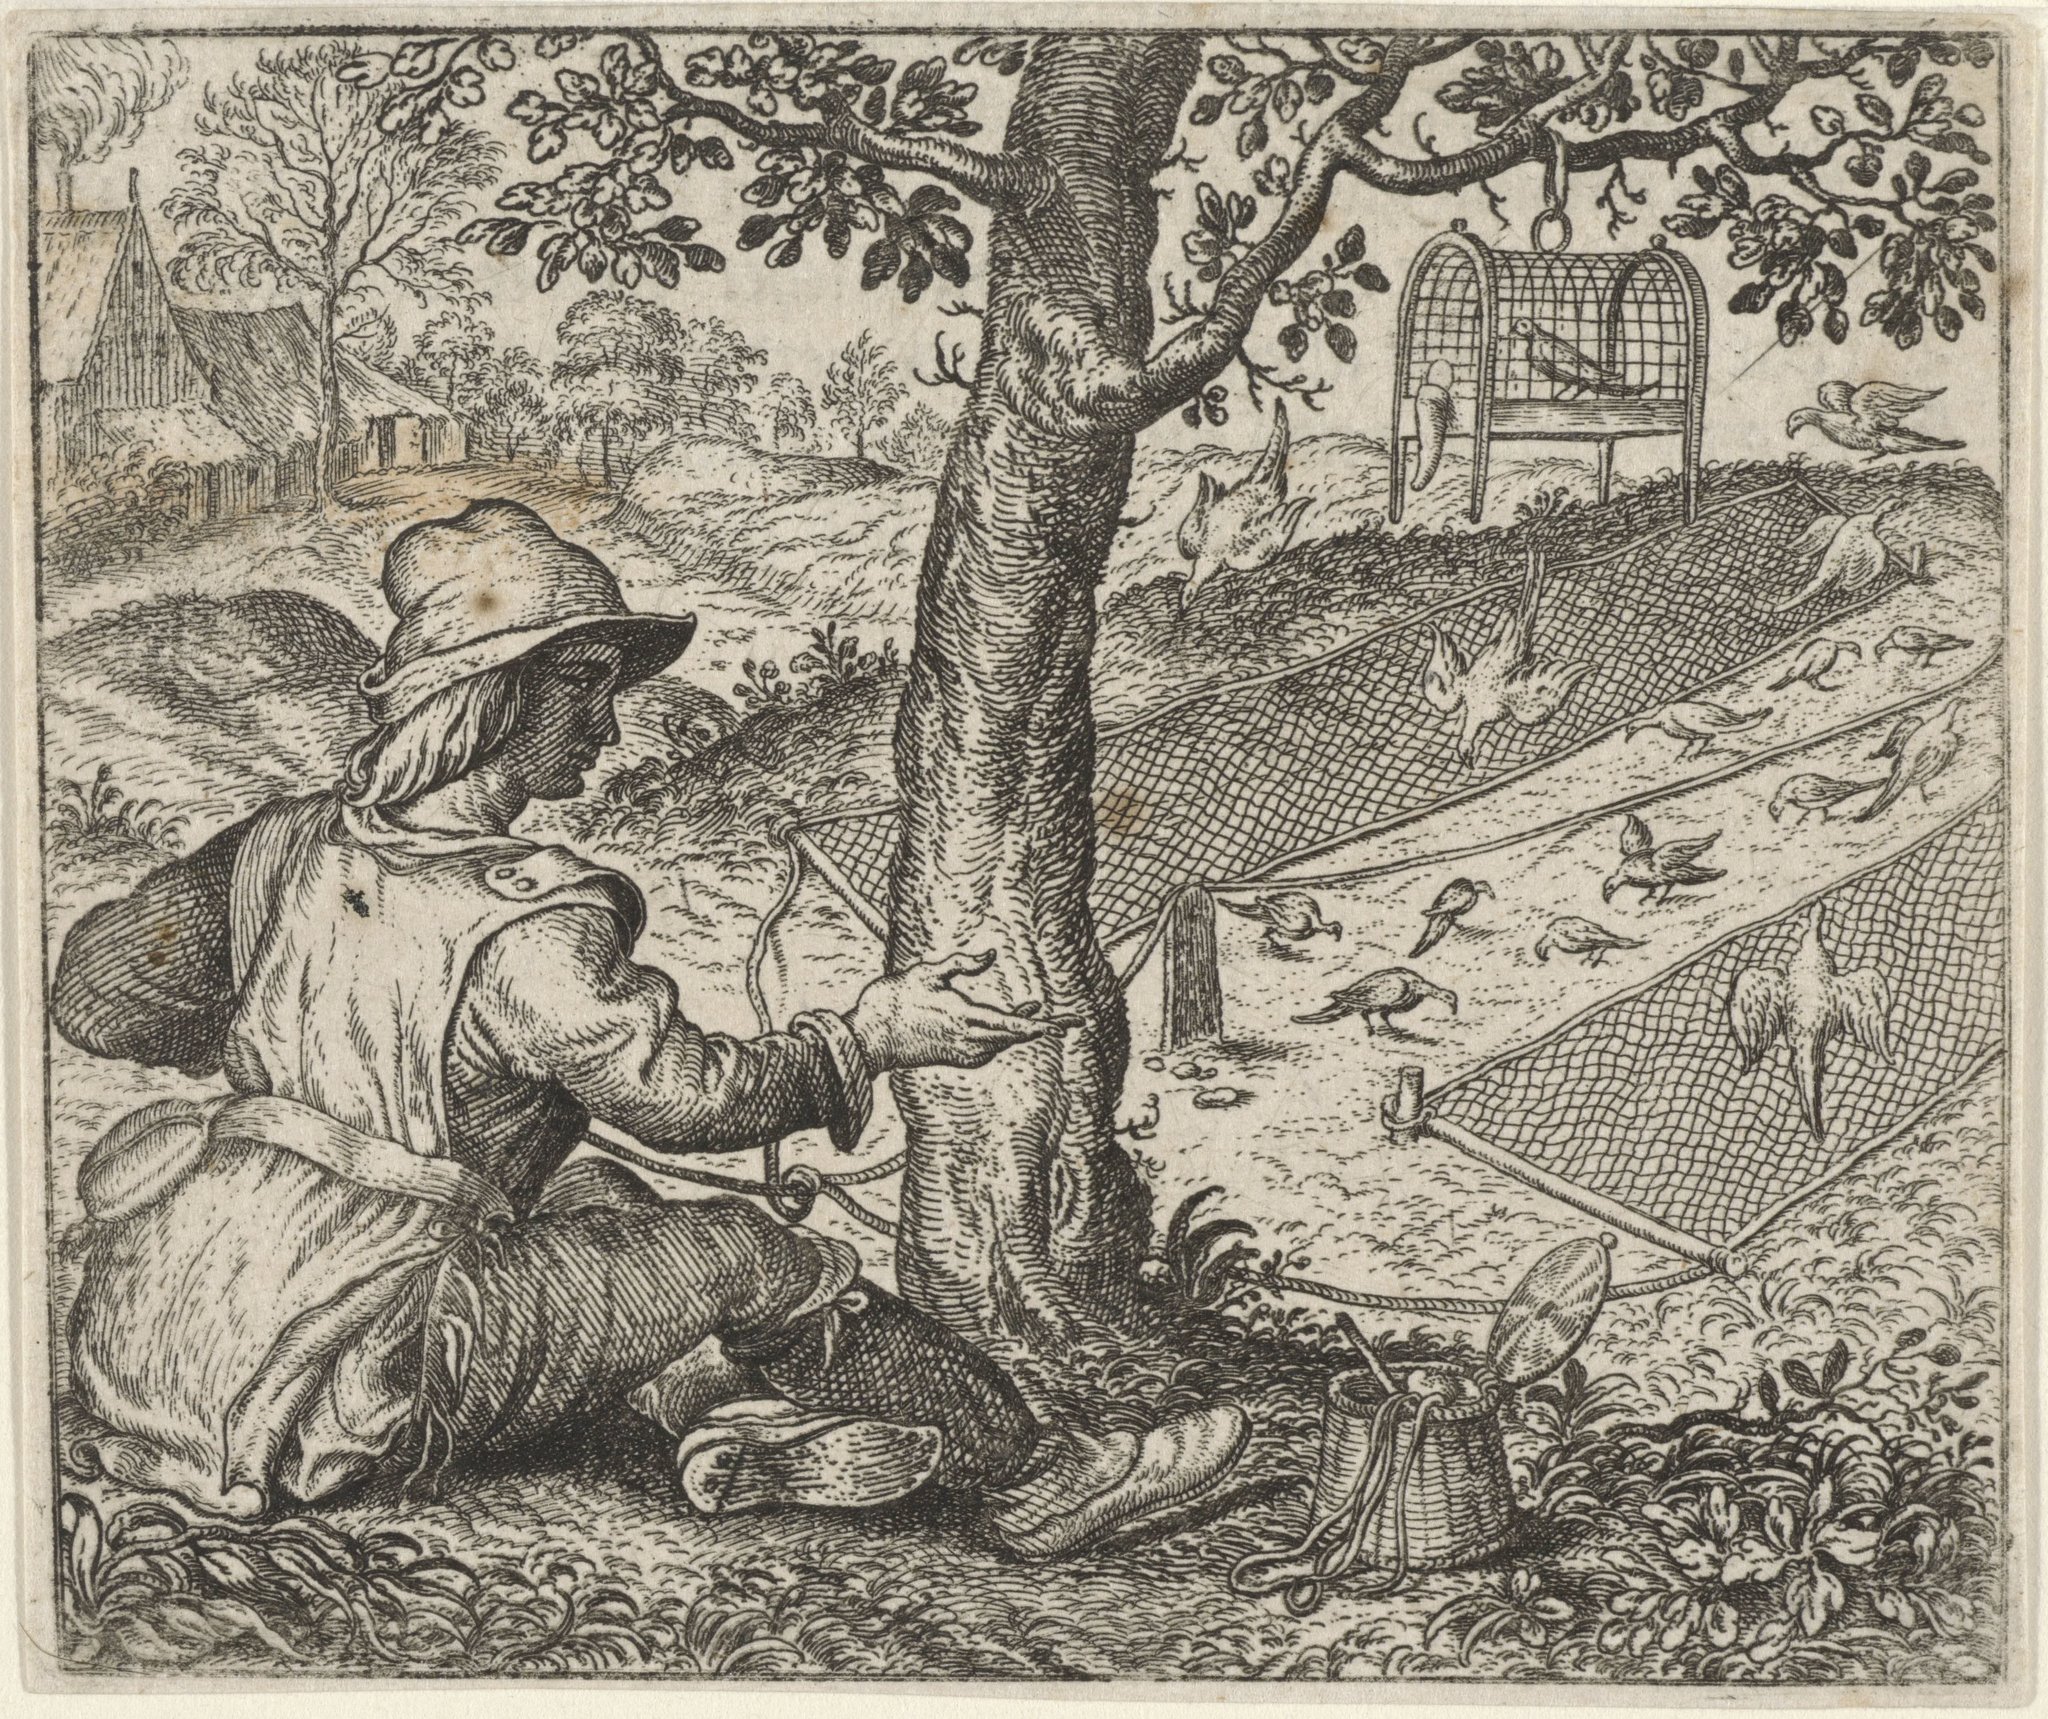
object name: book illustration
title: Fabel van de vogelaar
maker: aegidius sadeler (ii)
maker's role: draughtsman, print maker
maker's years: 1568-1629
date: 1608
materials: paper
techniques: engraving, etching, letterpress printing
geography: prague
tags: fables of aesop (with title) : use 85(...), birds, fowling, fowler, finch trap, finchery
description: Op de voorgrond een vogelvanger, zittend onder een boom. Hij houdt de touwen vast waarmee hij de netten kan aantrekken. De man heeft te veel zaad gestrooid waardoor veel verschillende vogels op de netten voedsel oppikken. Daardoor kan hij de val niet dicht trekken. Het is beter je te concentreren op een zaak dan te veel te willen in het leven.